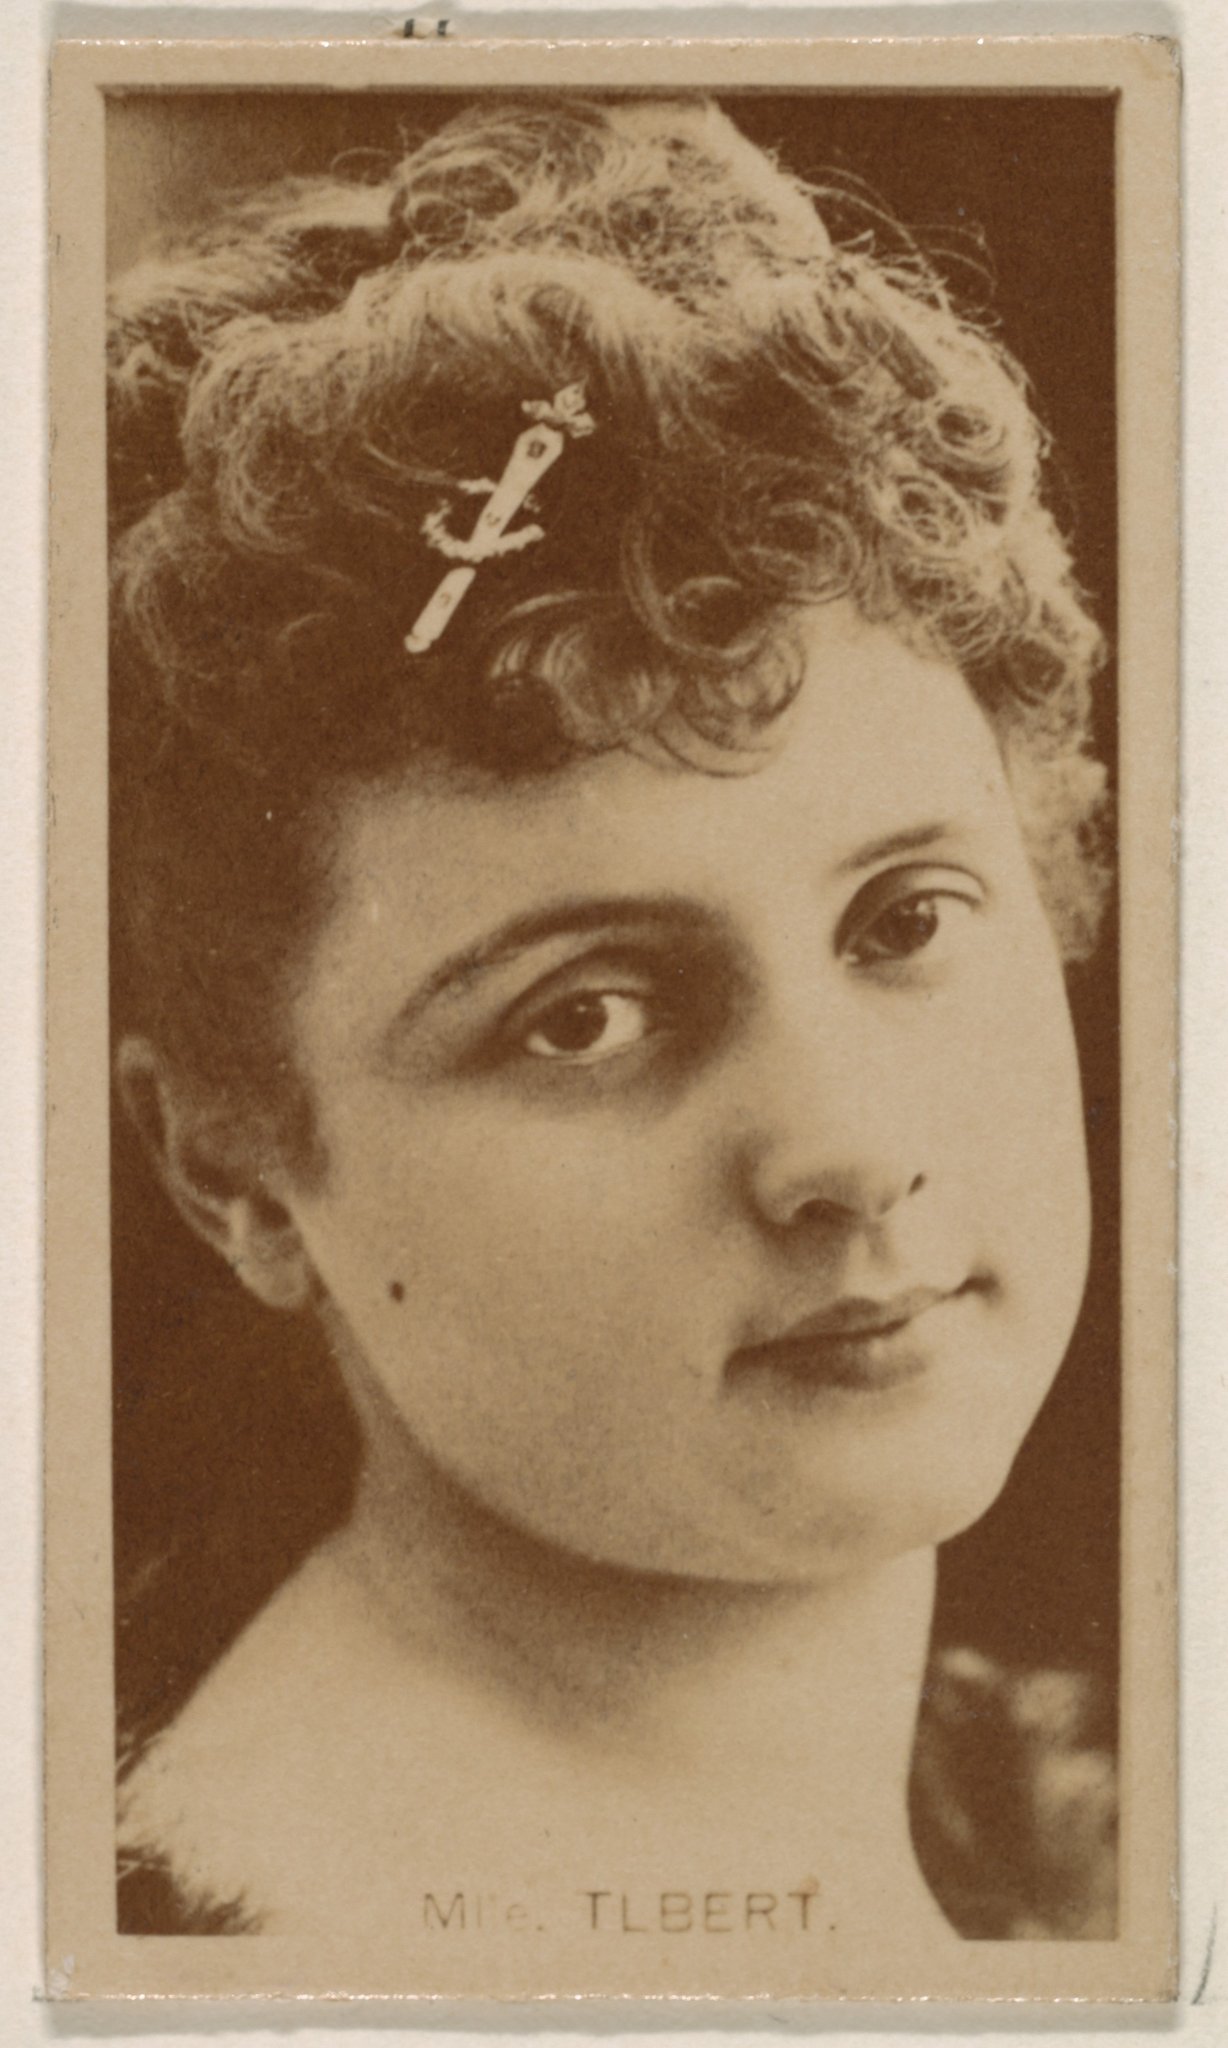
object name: photograph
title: Mlle. Tlbert, from the Actresses series (N245) issued by Kinney Brothers to promote Sweet Caporal Cigarettes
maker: kinney brothers tobacco company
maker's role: publisher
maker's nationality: american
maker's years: 1869-2011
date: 1890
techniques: albumen silver print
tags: portraits,women,actresses